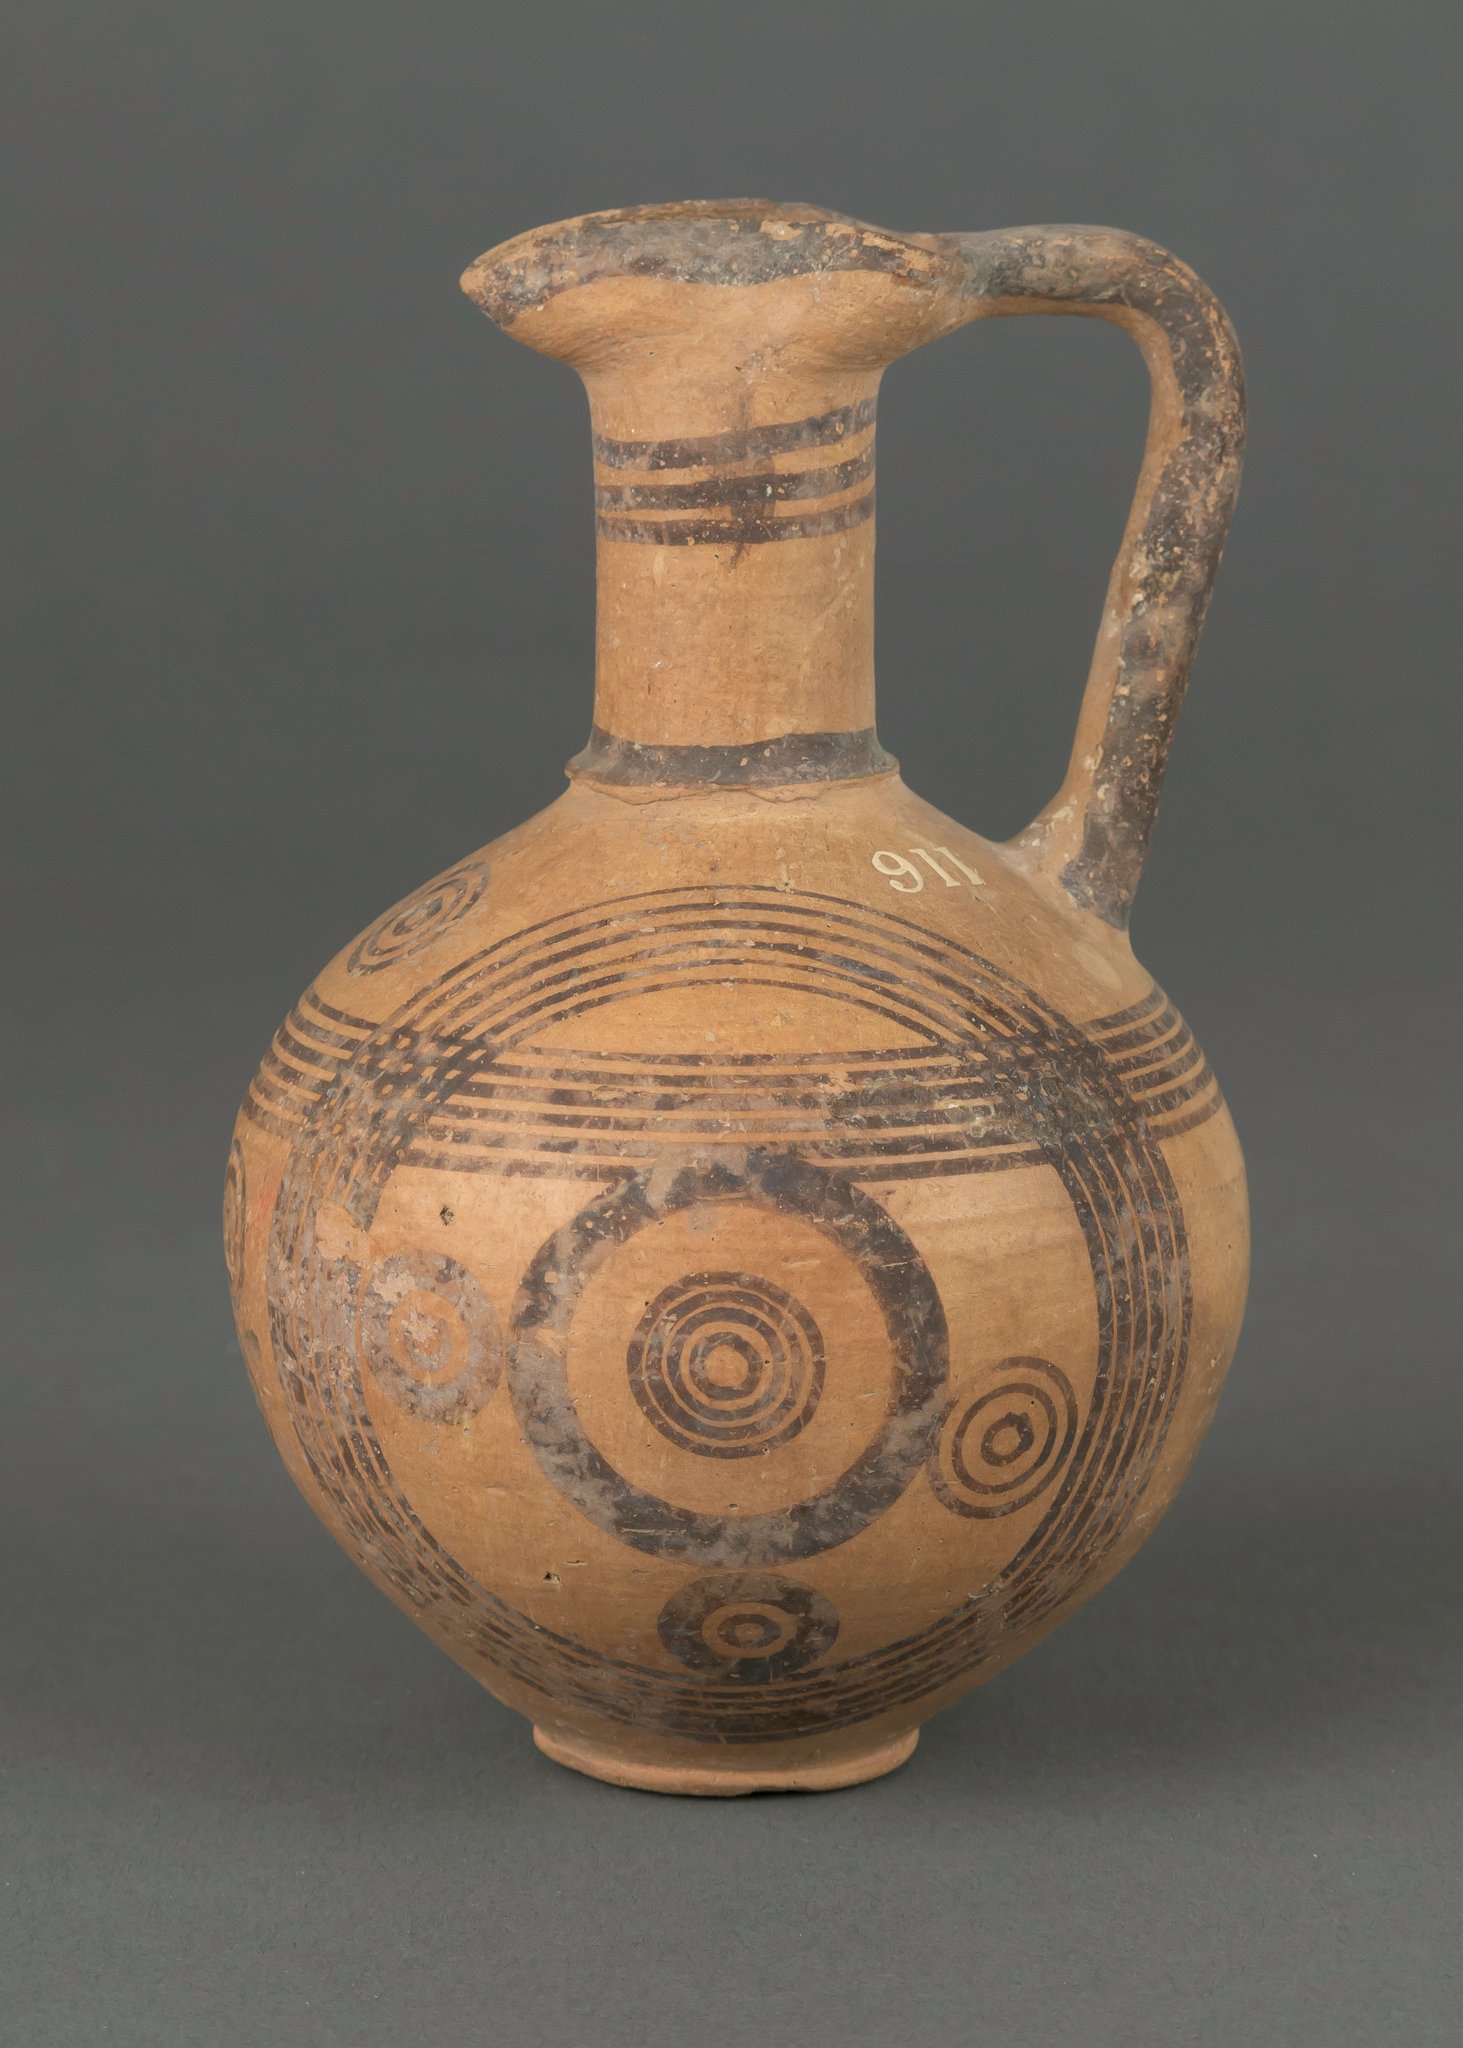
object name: juglet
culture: cypriot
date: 750-600 BCE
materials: terracotta